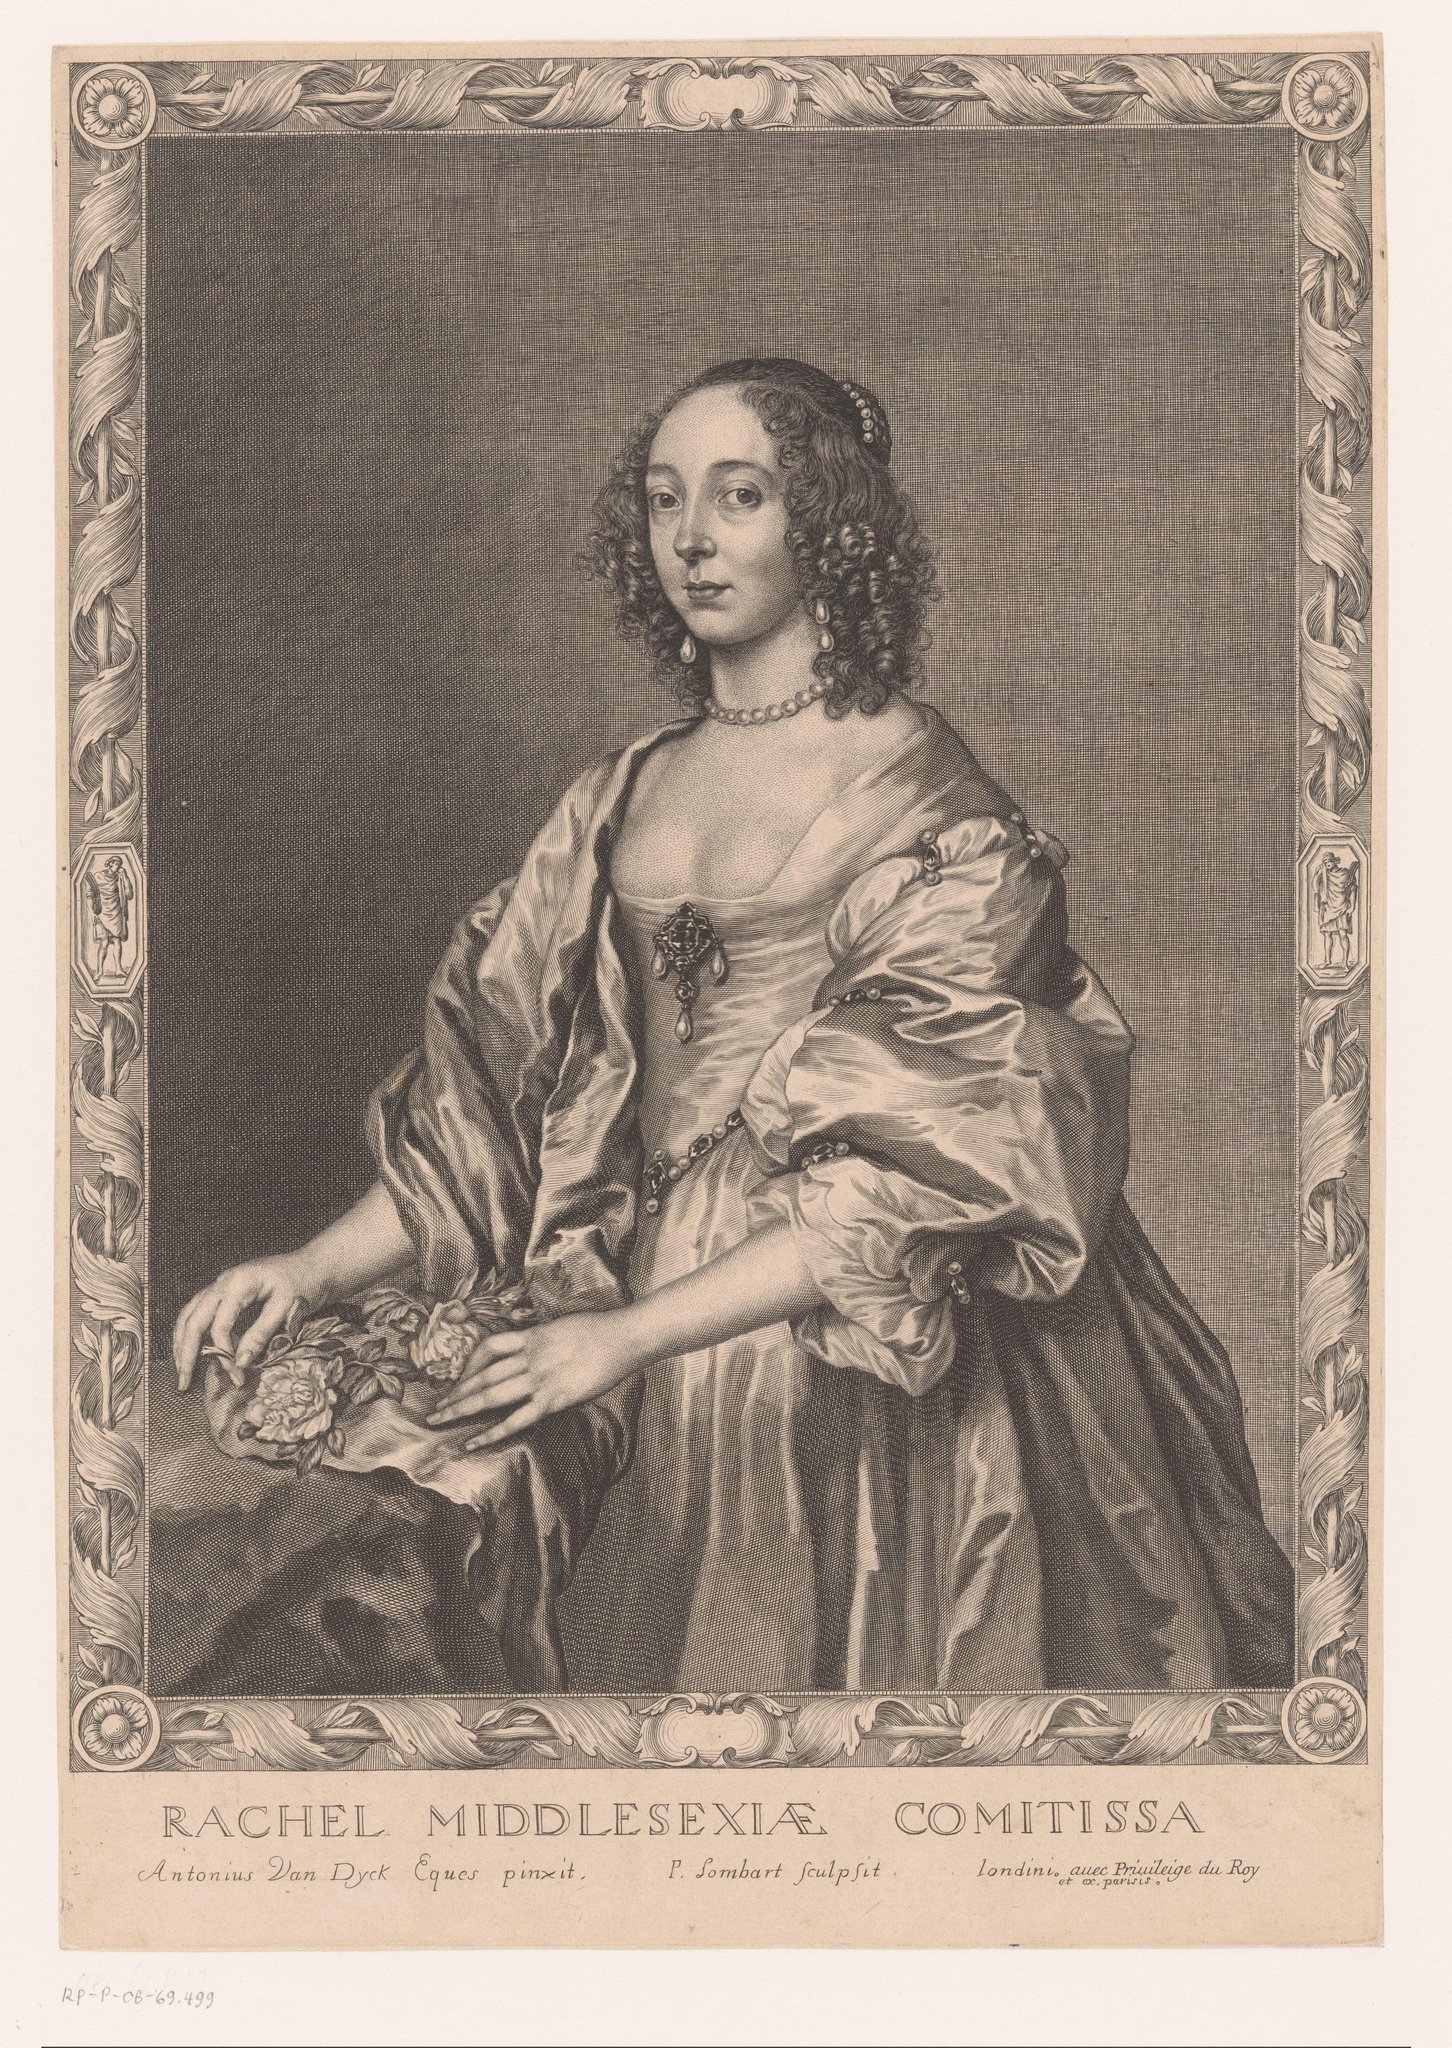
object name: print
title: Rachel Middleexiae comitissa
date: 1660-1663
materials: paper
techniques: engraving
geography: france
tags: historical persons - bb - woman, frame of painting, etc., nobility and patriciate; chivalry, knighthood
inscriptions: collector's mark: Lugt 240